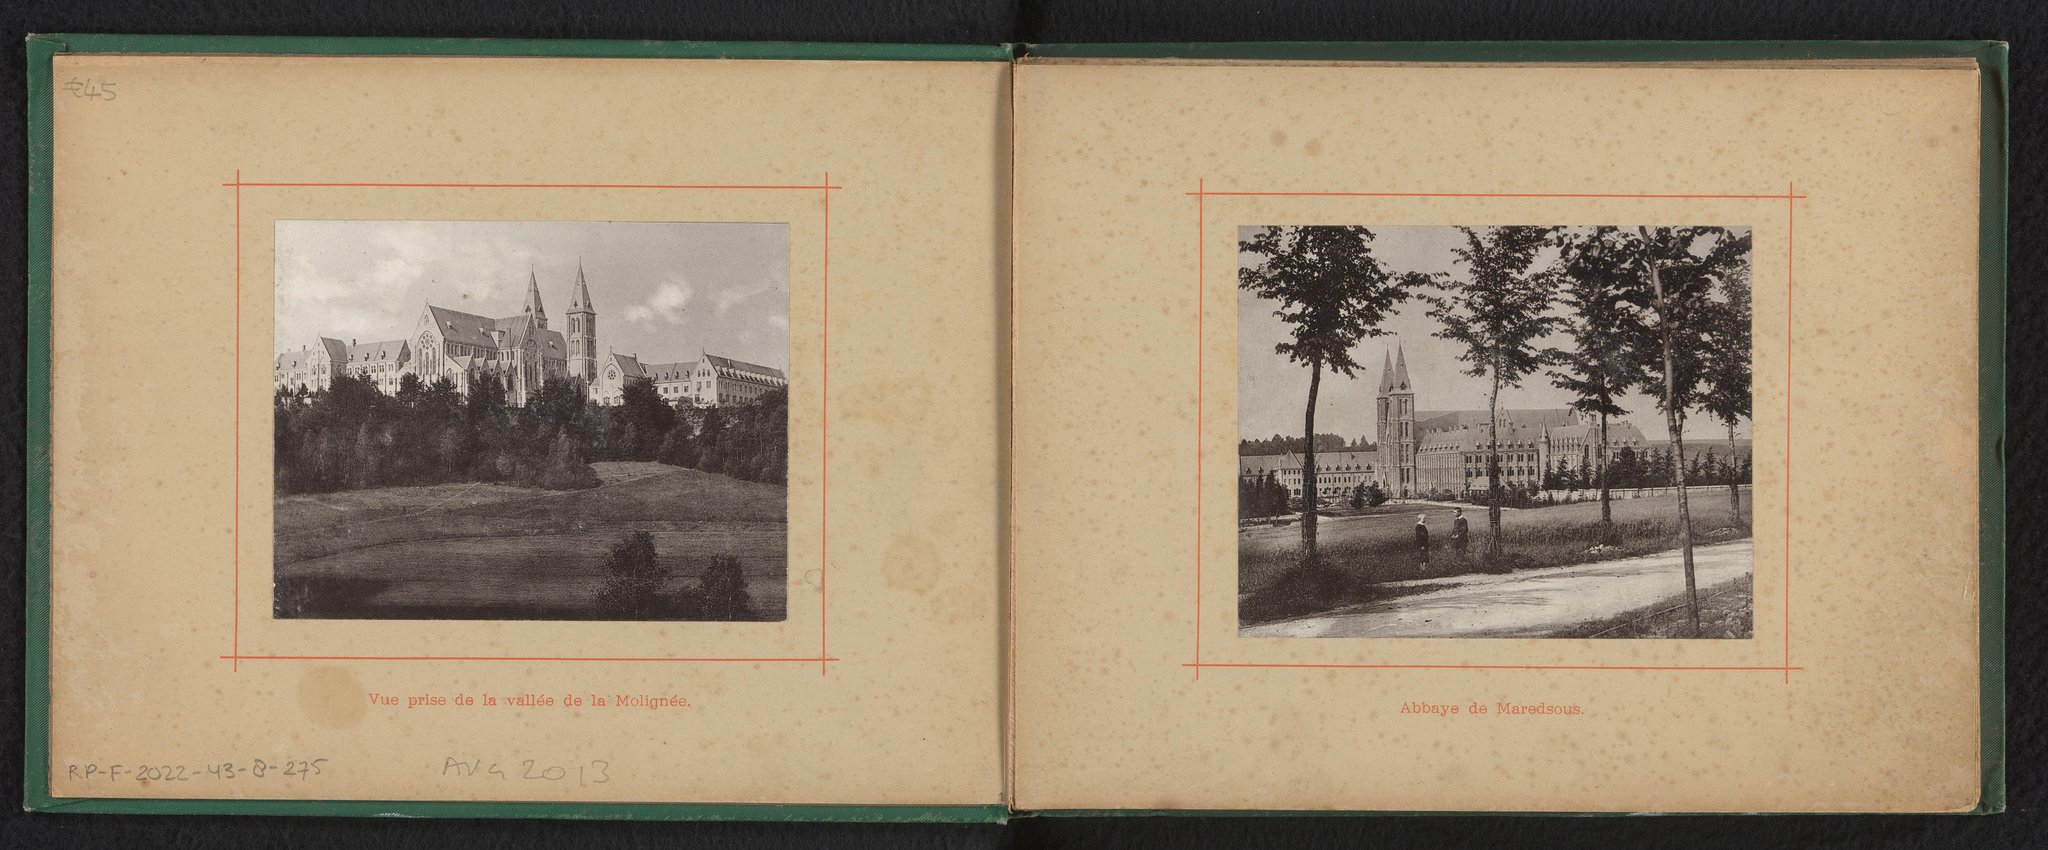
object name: photomechanical print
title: Abdij van Maredsous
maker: Anonymous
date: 1900-1905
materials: paper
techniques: photograph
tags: dale, valley, abbey, monastery, convent ~ roman catholic church